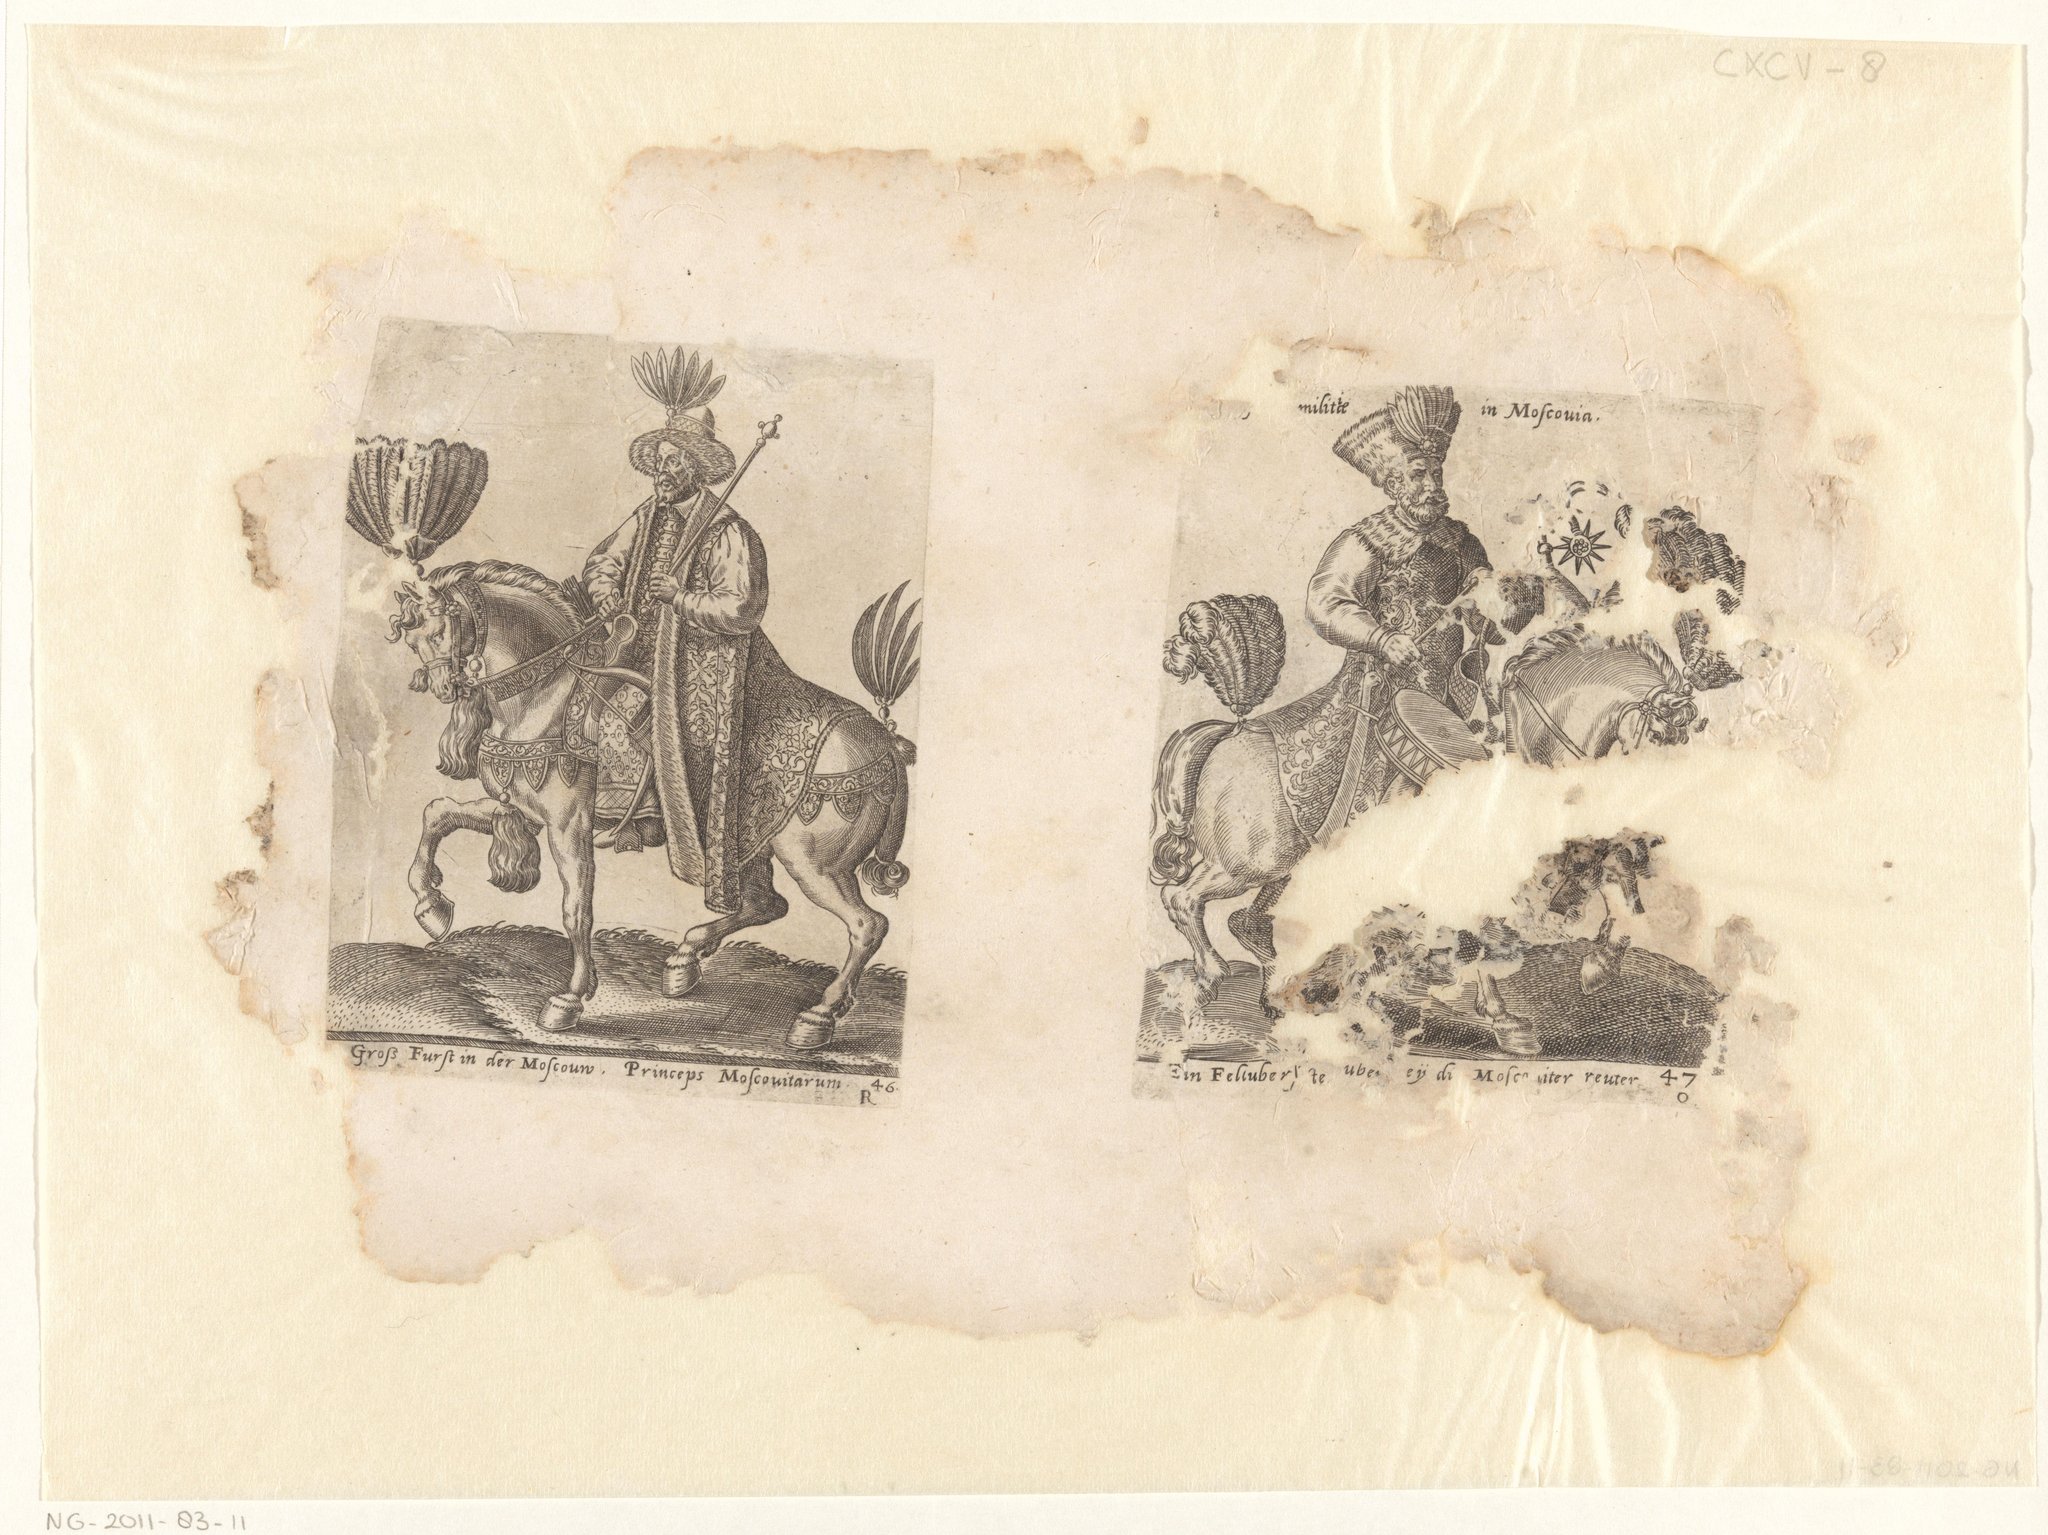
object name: print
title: Ruiterserie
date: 1576-1596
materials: paper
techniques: engraving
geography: cologne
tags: warfare; military affairs (+ cavalry, horsemen), folk costume, regional costume, military clothing and other equipment (uniforms, cap, armour, helmet, etc.)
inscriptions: watermark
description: Prent 46 en 47 uit een serie van 77, mogelijke serietitel Diversarum gentium armatura Equestris. Latere editie van serie Equitum Descripcio, Quomodo Equestres (...). De prenten in de Nova Zembla collectie zijn tijdens een expeditie van Willem Barendsz en Jacob van Heemskerk in 1596-1597 noodgedwongen in het winterkamp, het ‘Behouden Huis’, op het eiland achtergelaten. De prenten waren in één of meerdere stapels als handelswaar meegenomen vanuit Amsterdam. Bijna drie eeuwen later, in 1871, keerde de Noor Elling Carlsen terug naar Nova Zembla en vond daar de restanten van het ‘Behouden Huis, inclusief een groot deel van de inventaris. Een deel van de prenten, in de vorm van aaneengekoekte kluiten, werd toen ook teruggevonden. De papierkluiten waren soms op meerdere plekken gebroken. Tussen 1975-1979 zijn de prenten van elkaar gescheiden. Dit leverde in totaal ca. 1000 fragmenten van ca. 400 afdrukken van ca. 150 verschillende prenten op. Voor zover mogelijk zijn de fragmenten samengevoegd en zijn de prenten gereconstrueerd.